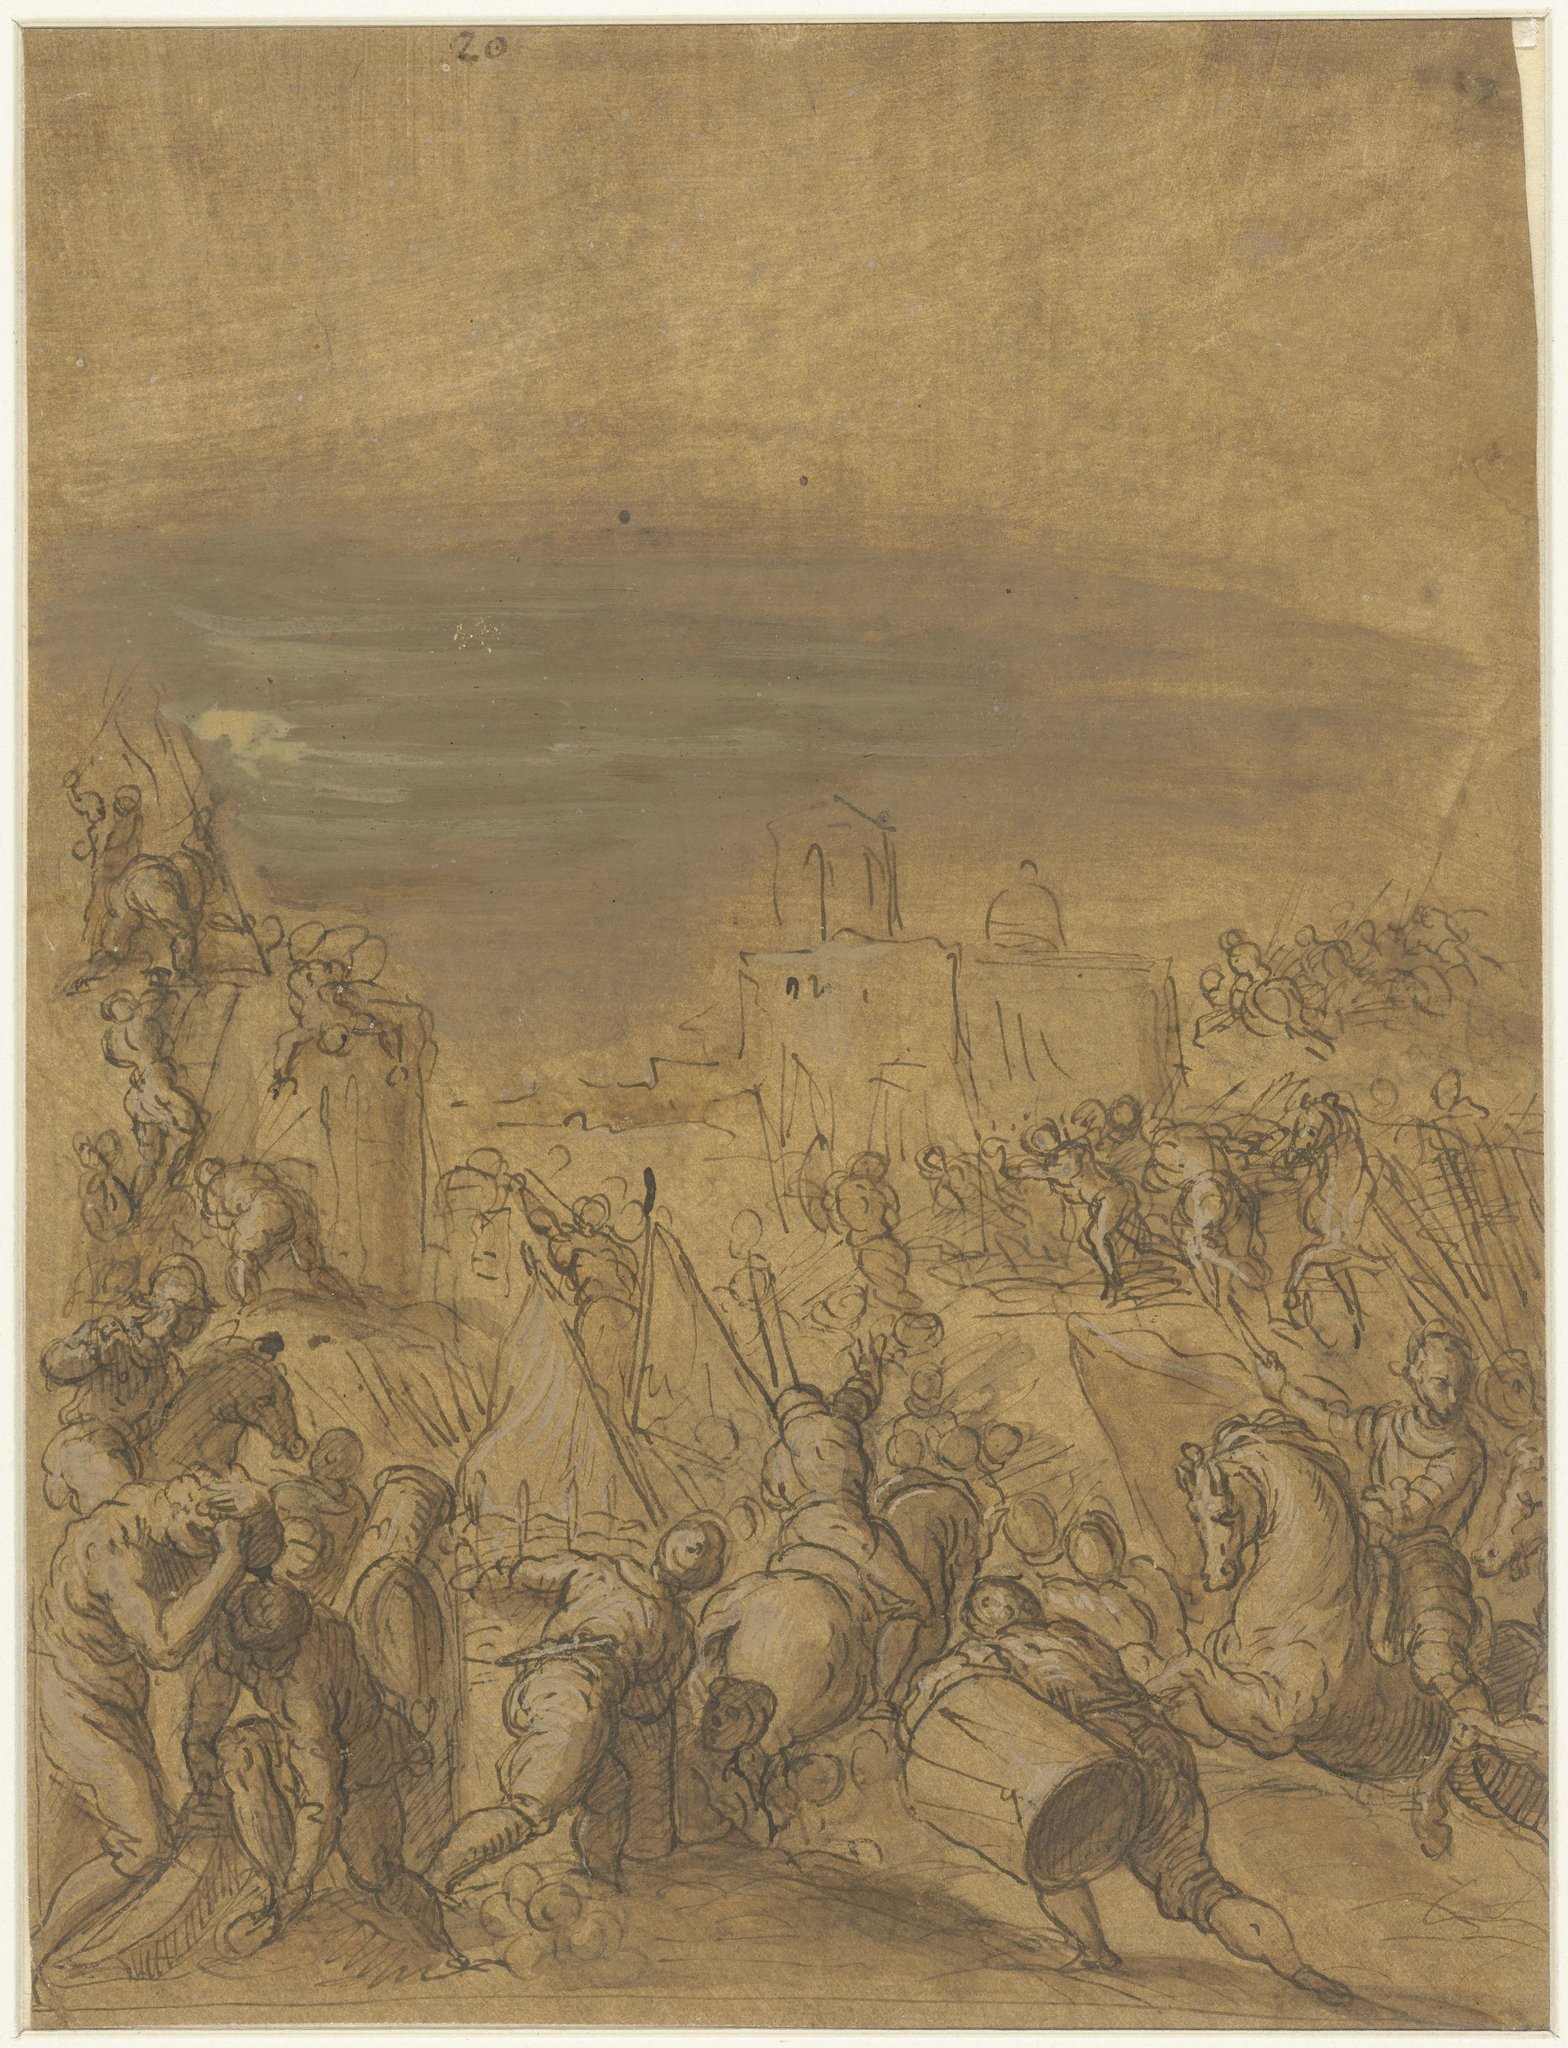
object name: drawing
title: Verovering van St. Quentin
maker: jacopo palma (il giovane)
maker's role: draughtsman, painter, print maker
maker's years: 1544-1628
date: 1575-1585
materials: ink, paper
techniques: brush, pen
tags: battle of st. quentin (1871)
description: Voorstudie voor schilderij. Blad afkomstig uit een schetsboek van Palma, vroeger bijeen in de verzameling Liechtenstein.